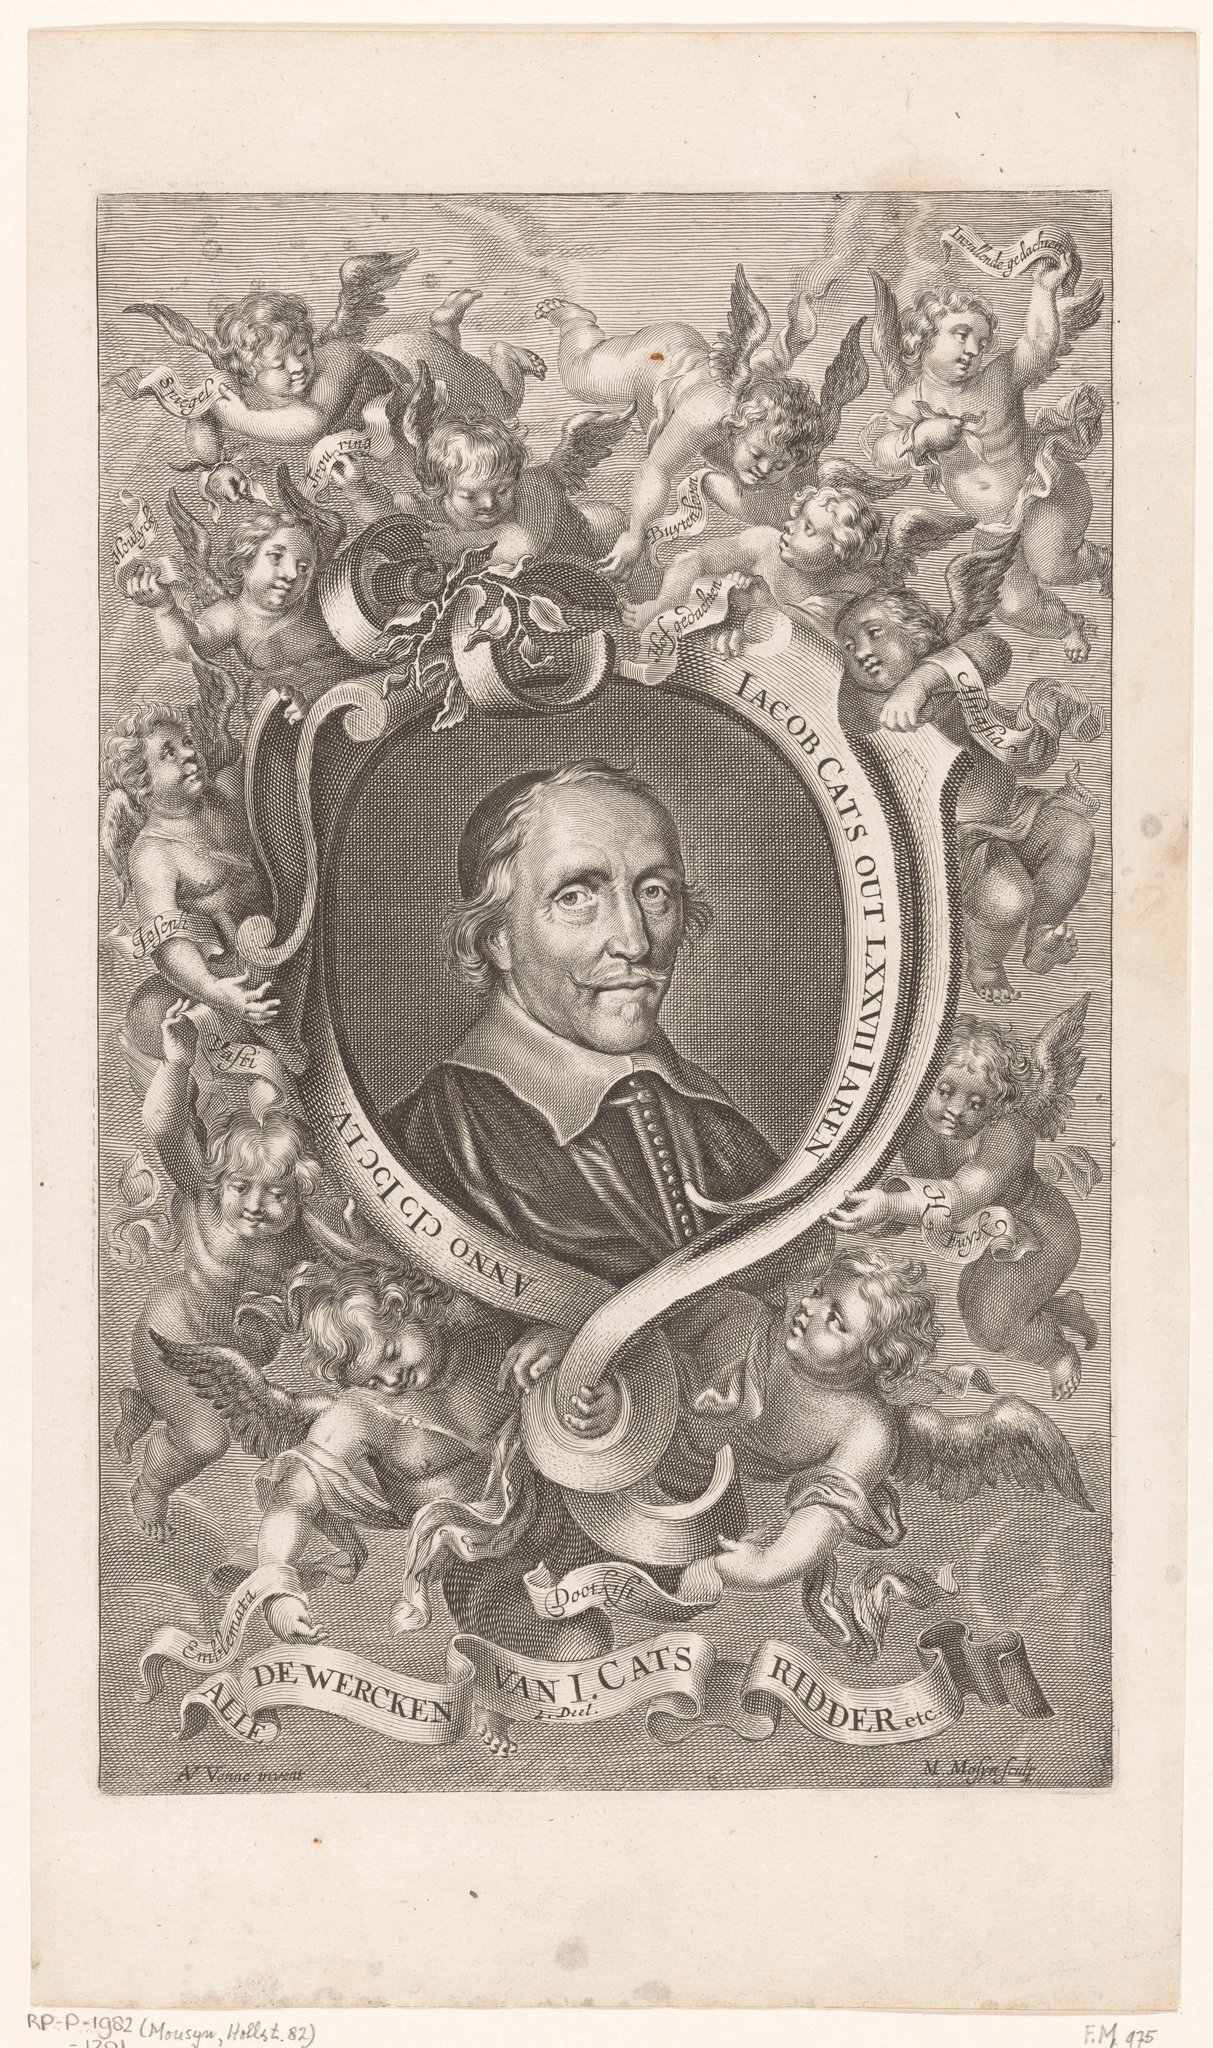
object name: titelblad, titelpagina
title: Portret van Jacob Cats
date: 1655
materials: paper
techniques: engraving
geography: amsterdam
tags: the hague, jacob cats (1577-1660), portrait of a writer, cupids: 'amores', 'amoretti', 'putti'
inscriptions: collector's mark: Lugt 2760, collector's mark: Lugt 2228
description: Portret van schrijver en dichter Jacob Cats in een ornamentele lijst, omgeven en gedragen door putti. De putti tonen banderollen met de titels van Cats' werken.